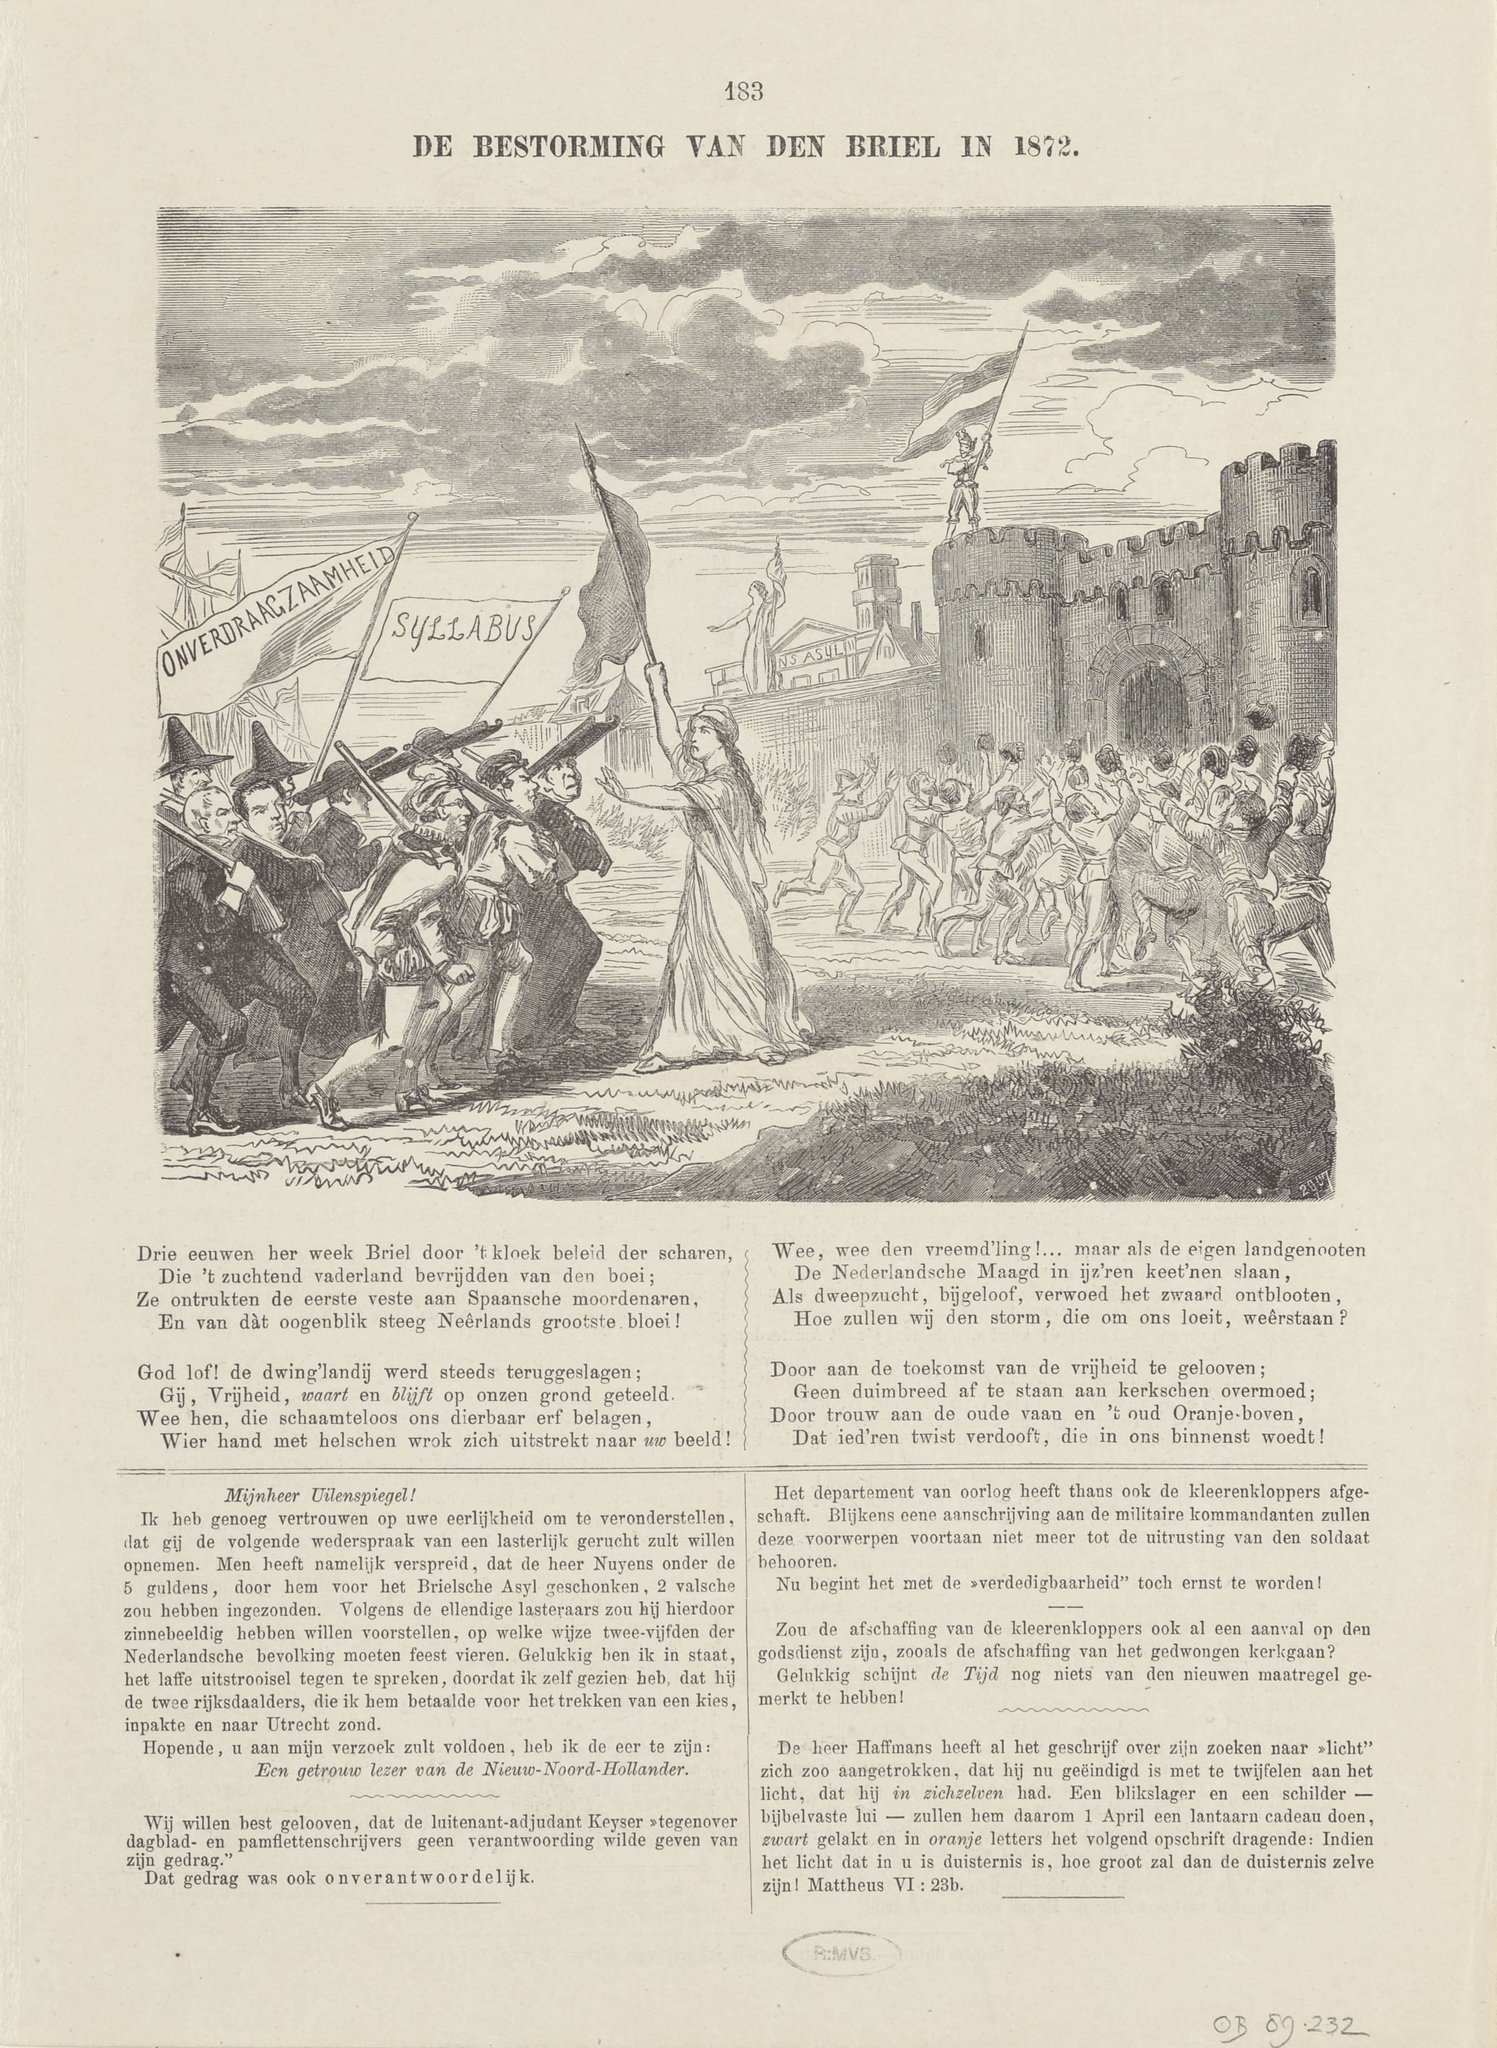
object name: cartoon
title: De bestorming van Den Briel in 1872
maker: Anonymous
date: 1872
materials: paper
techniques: letterpress printing, engraving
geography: netherlands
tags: capture of city (after the siege), brielle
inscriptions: collector's mark: Lugt 2228, signature: ‘2007’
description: Spotprent met rechts de inname van Den Briel op 1 april 1572. Links op de voorgrond wordt een groep mannen (politici) uit 1872 met vaandels met opschriften 'Onverdraagzaamheid' en 'Syllabus' door de Nederlandse Maagd tegengehouden. Onder de voorstelling vier vierregelige verzen.